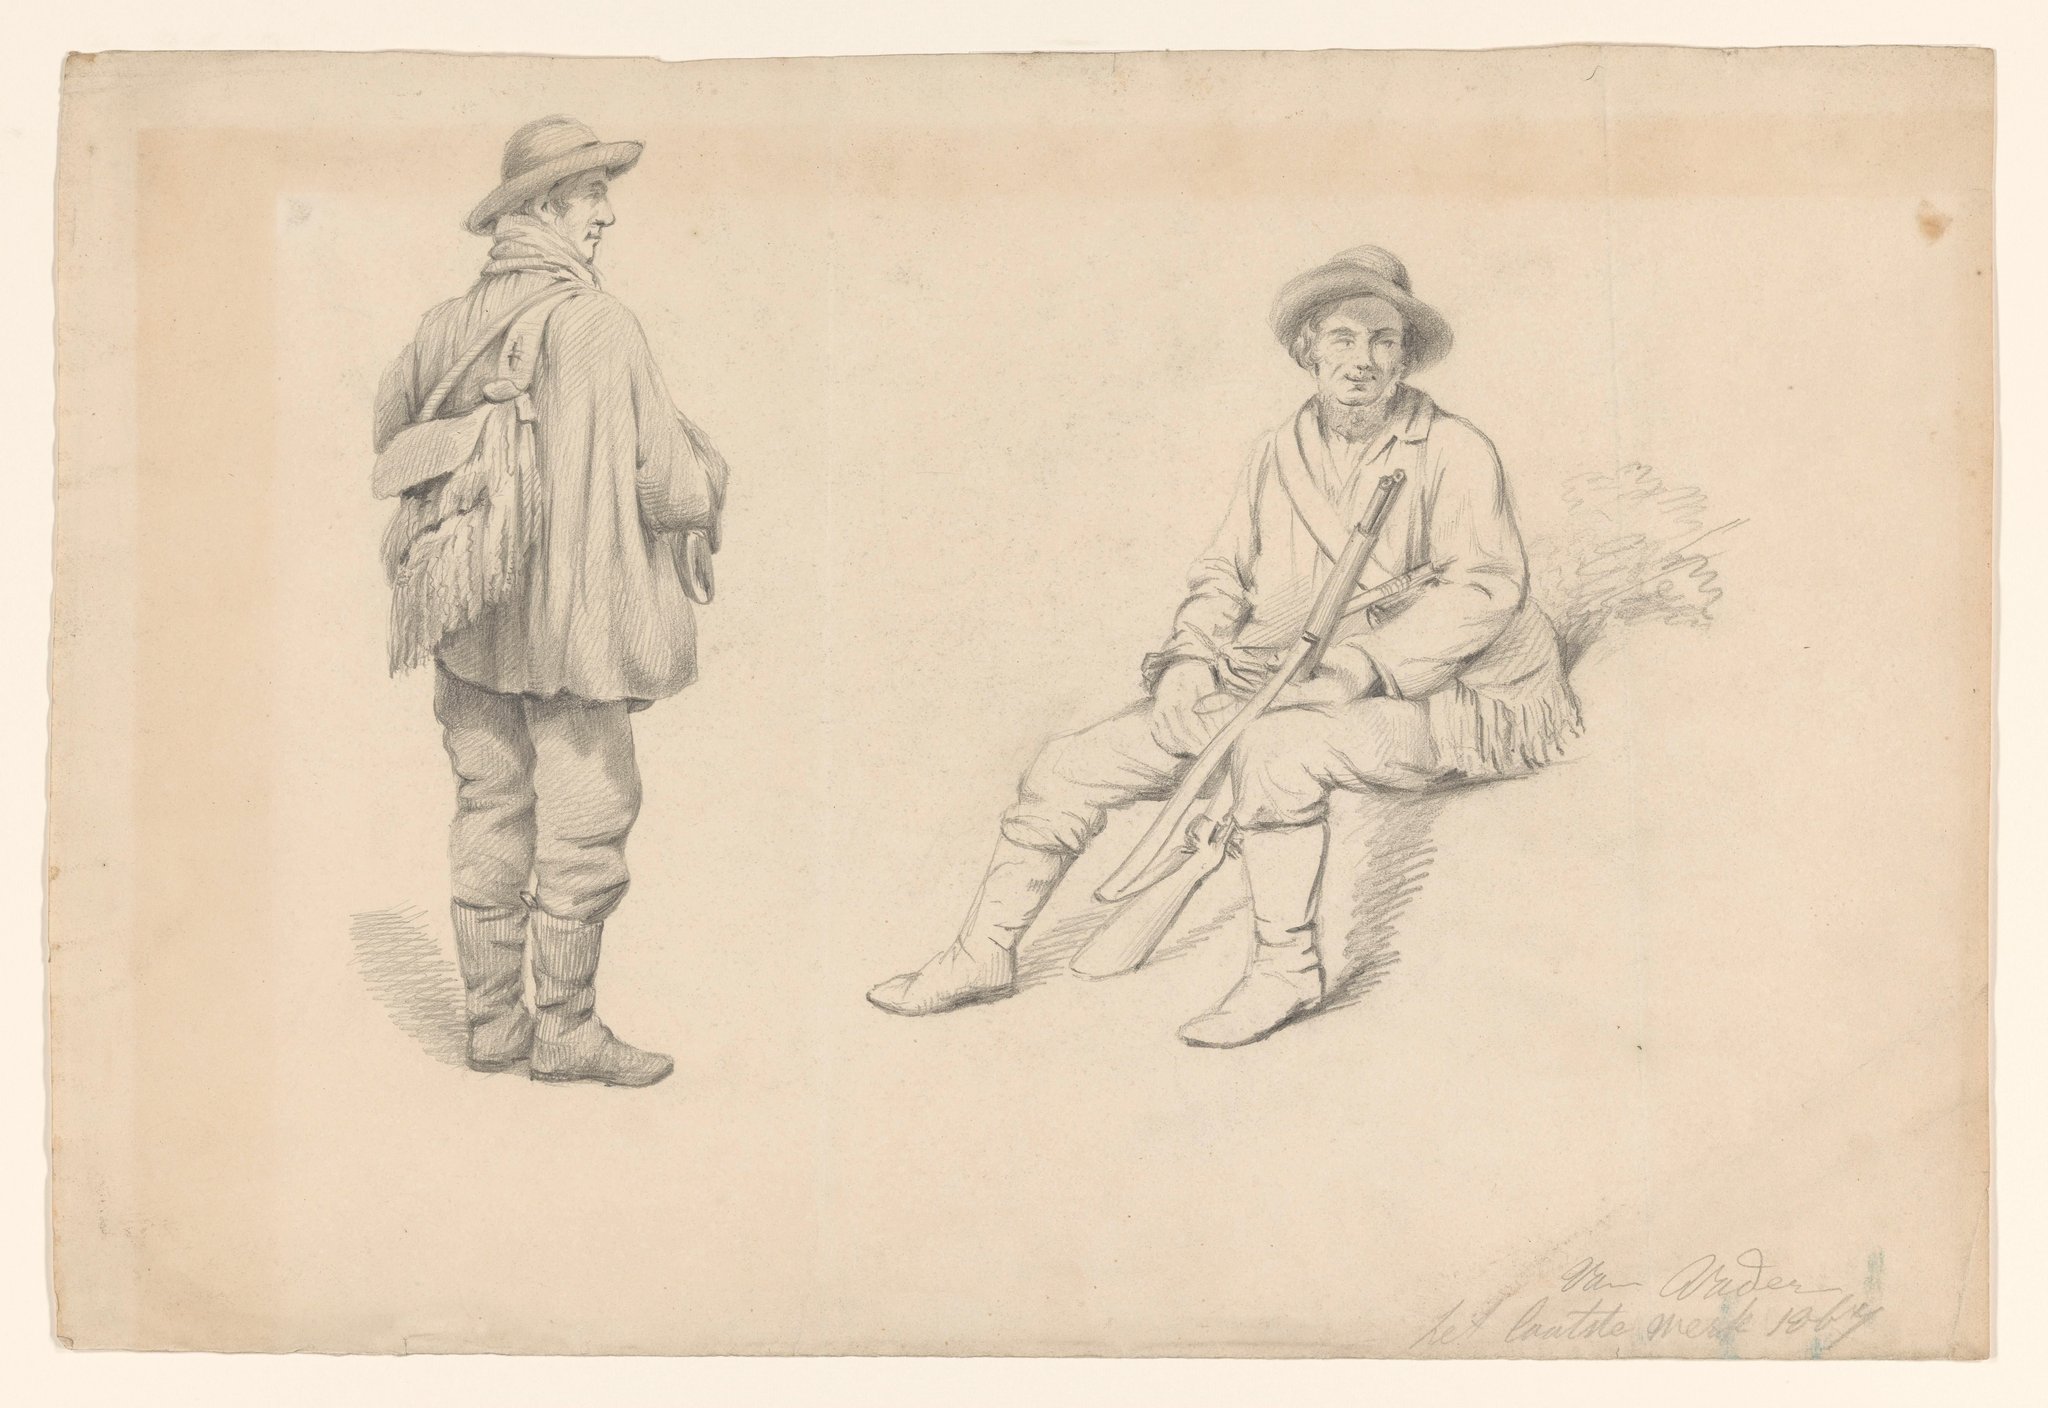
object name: drawing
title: Staande en zittende jager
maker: alexander cranendoncq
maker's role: draughtsman, print maker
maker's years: 1799-1869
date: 1867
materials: paper, pencil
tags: hunter